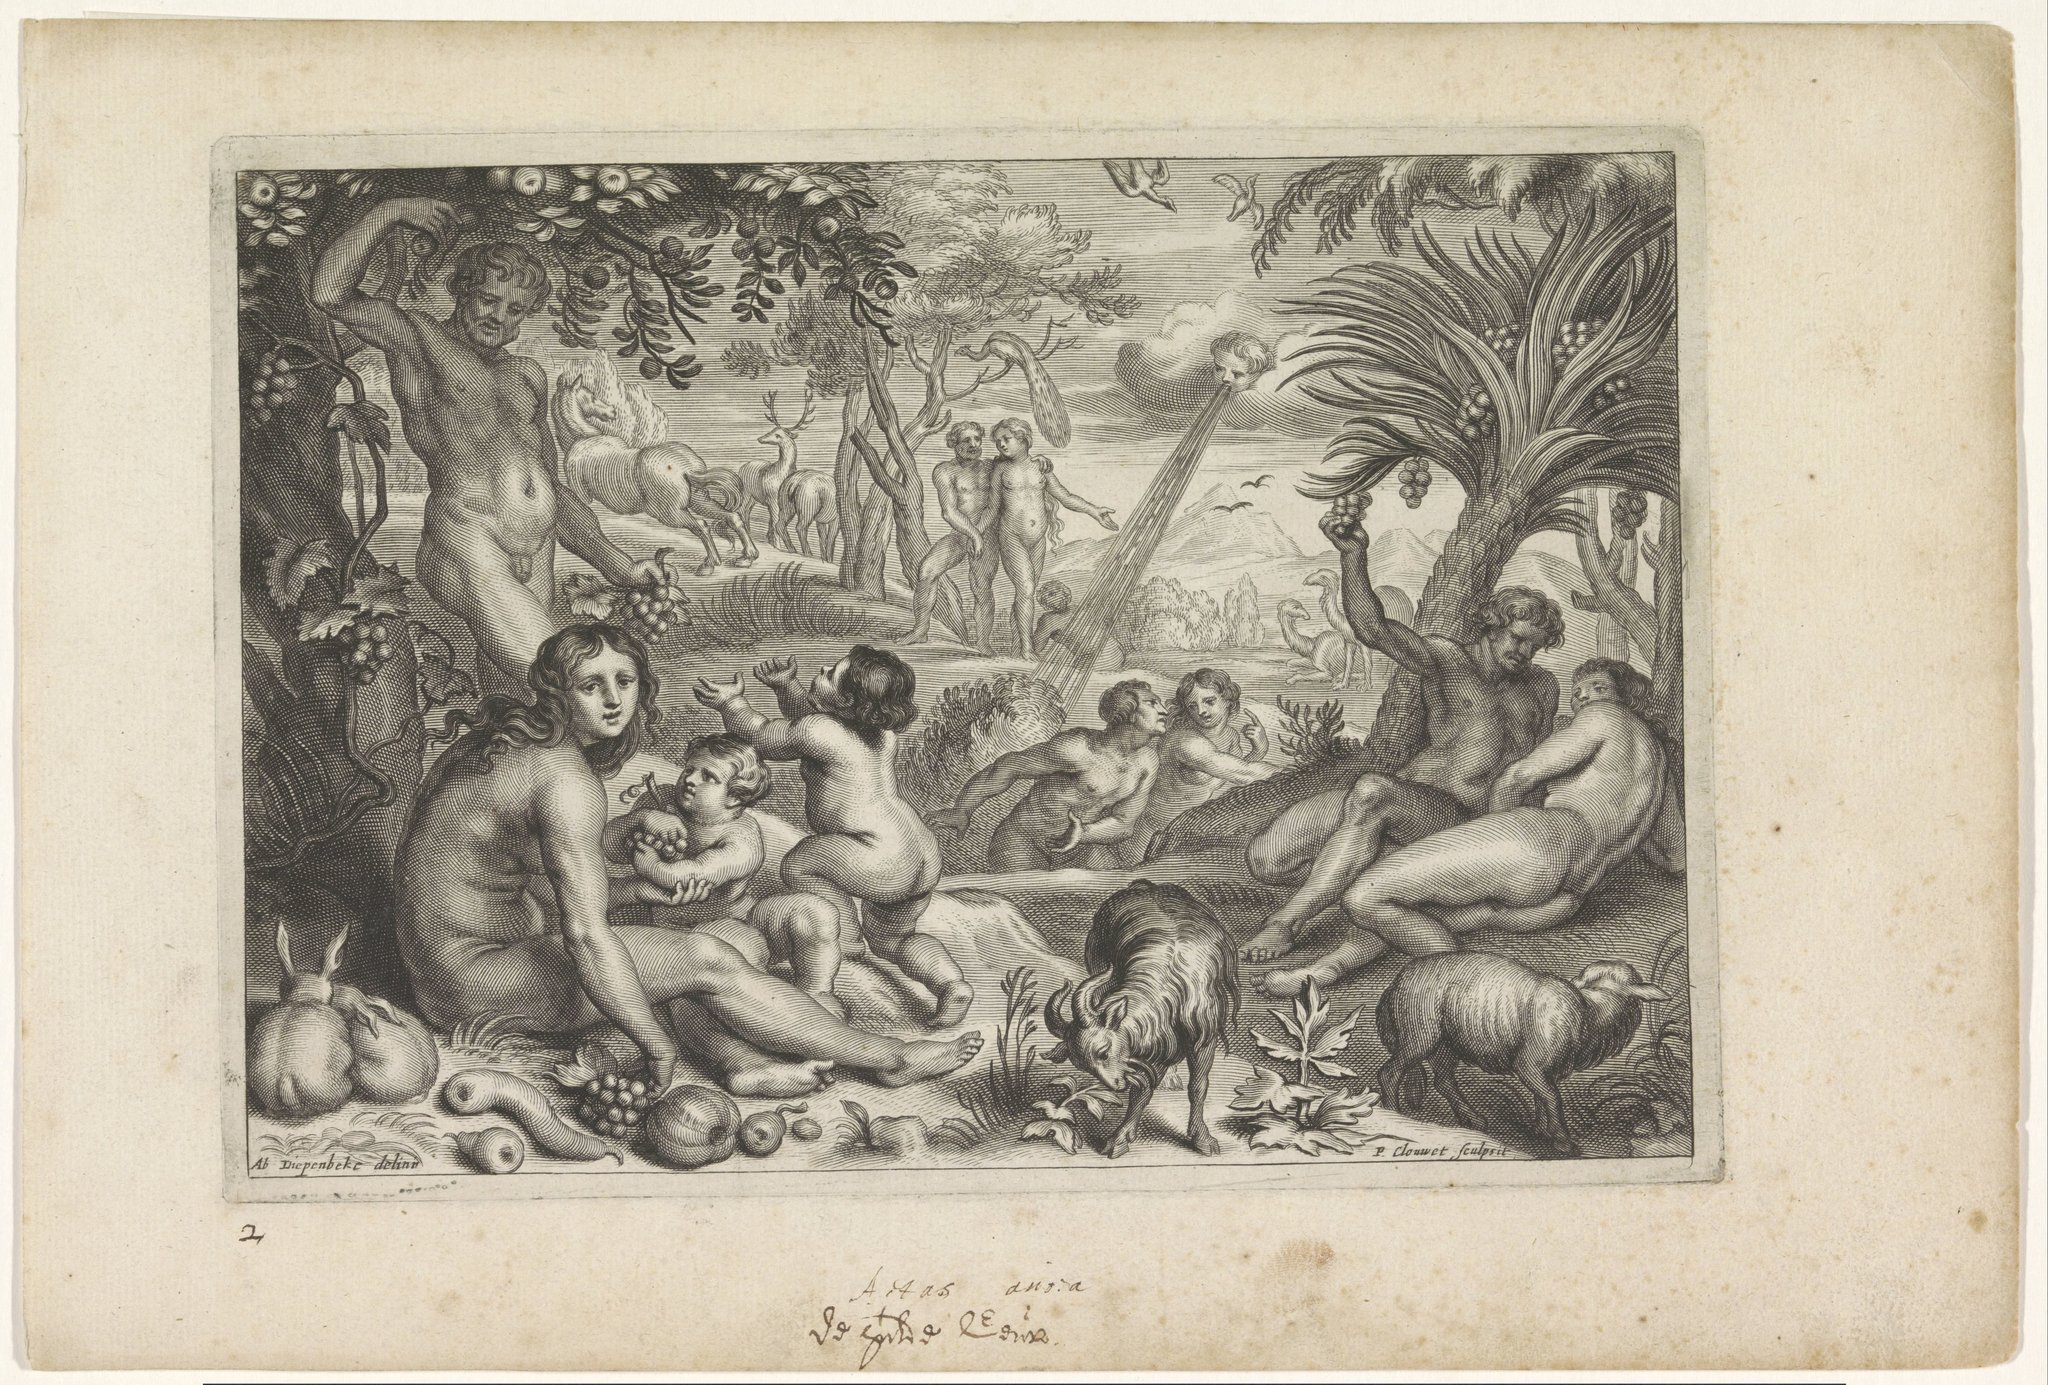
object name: print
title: De Gouden Eeuw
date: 1636-1670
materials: paper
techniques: engraving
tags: the golden age, 'aetas aurea'; men live happily, gathering fruits under the reign of saturn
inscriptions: collector's mark: ‘Hinloopen’, number: ‘2’, annotation: ‘Aetas aurea/ de gulde eeuw’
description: Deze incomplete serie, bestaande uit 77 van de in totaal 85 prenten met scènes uit Ovidius' Metamorfosen, werd in 1709 samen met Ovidius-illustraties van Tempesta, Goltzius en Le Pautre in één album, Schijnvoet nummer 43, ingebonden. In de negentiende eeuw werd deze band weer uit elkaar gehaald.